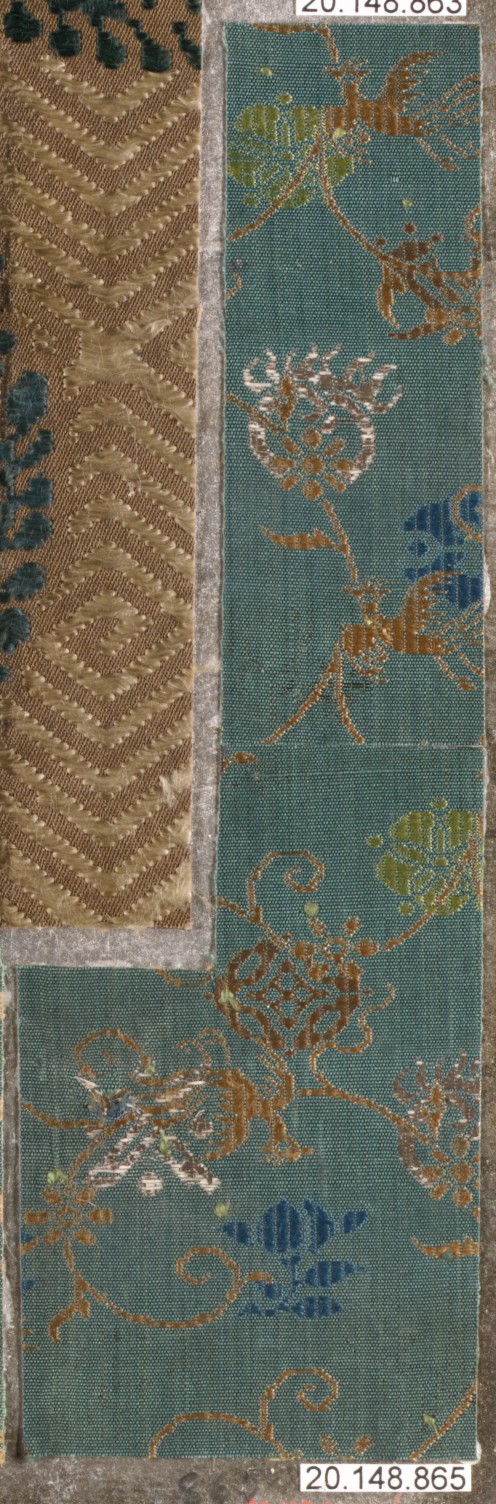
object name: piece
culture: japanese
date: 1701-1800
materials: silk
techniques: compound weave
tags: flowers